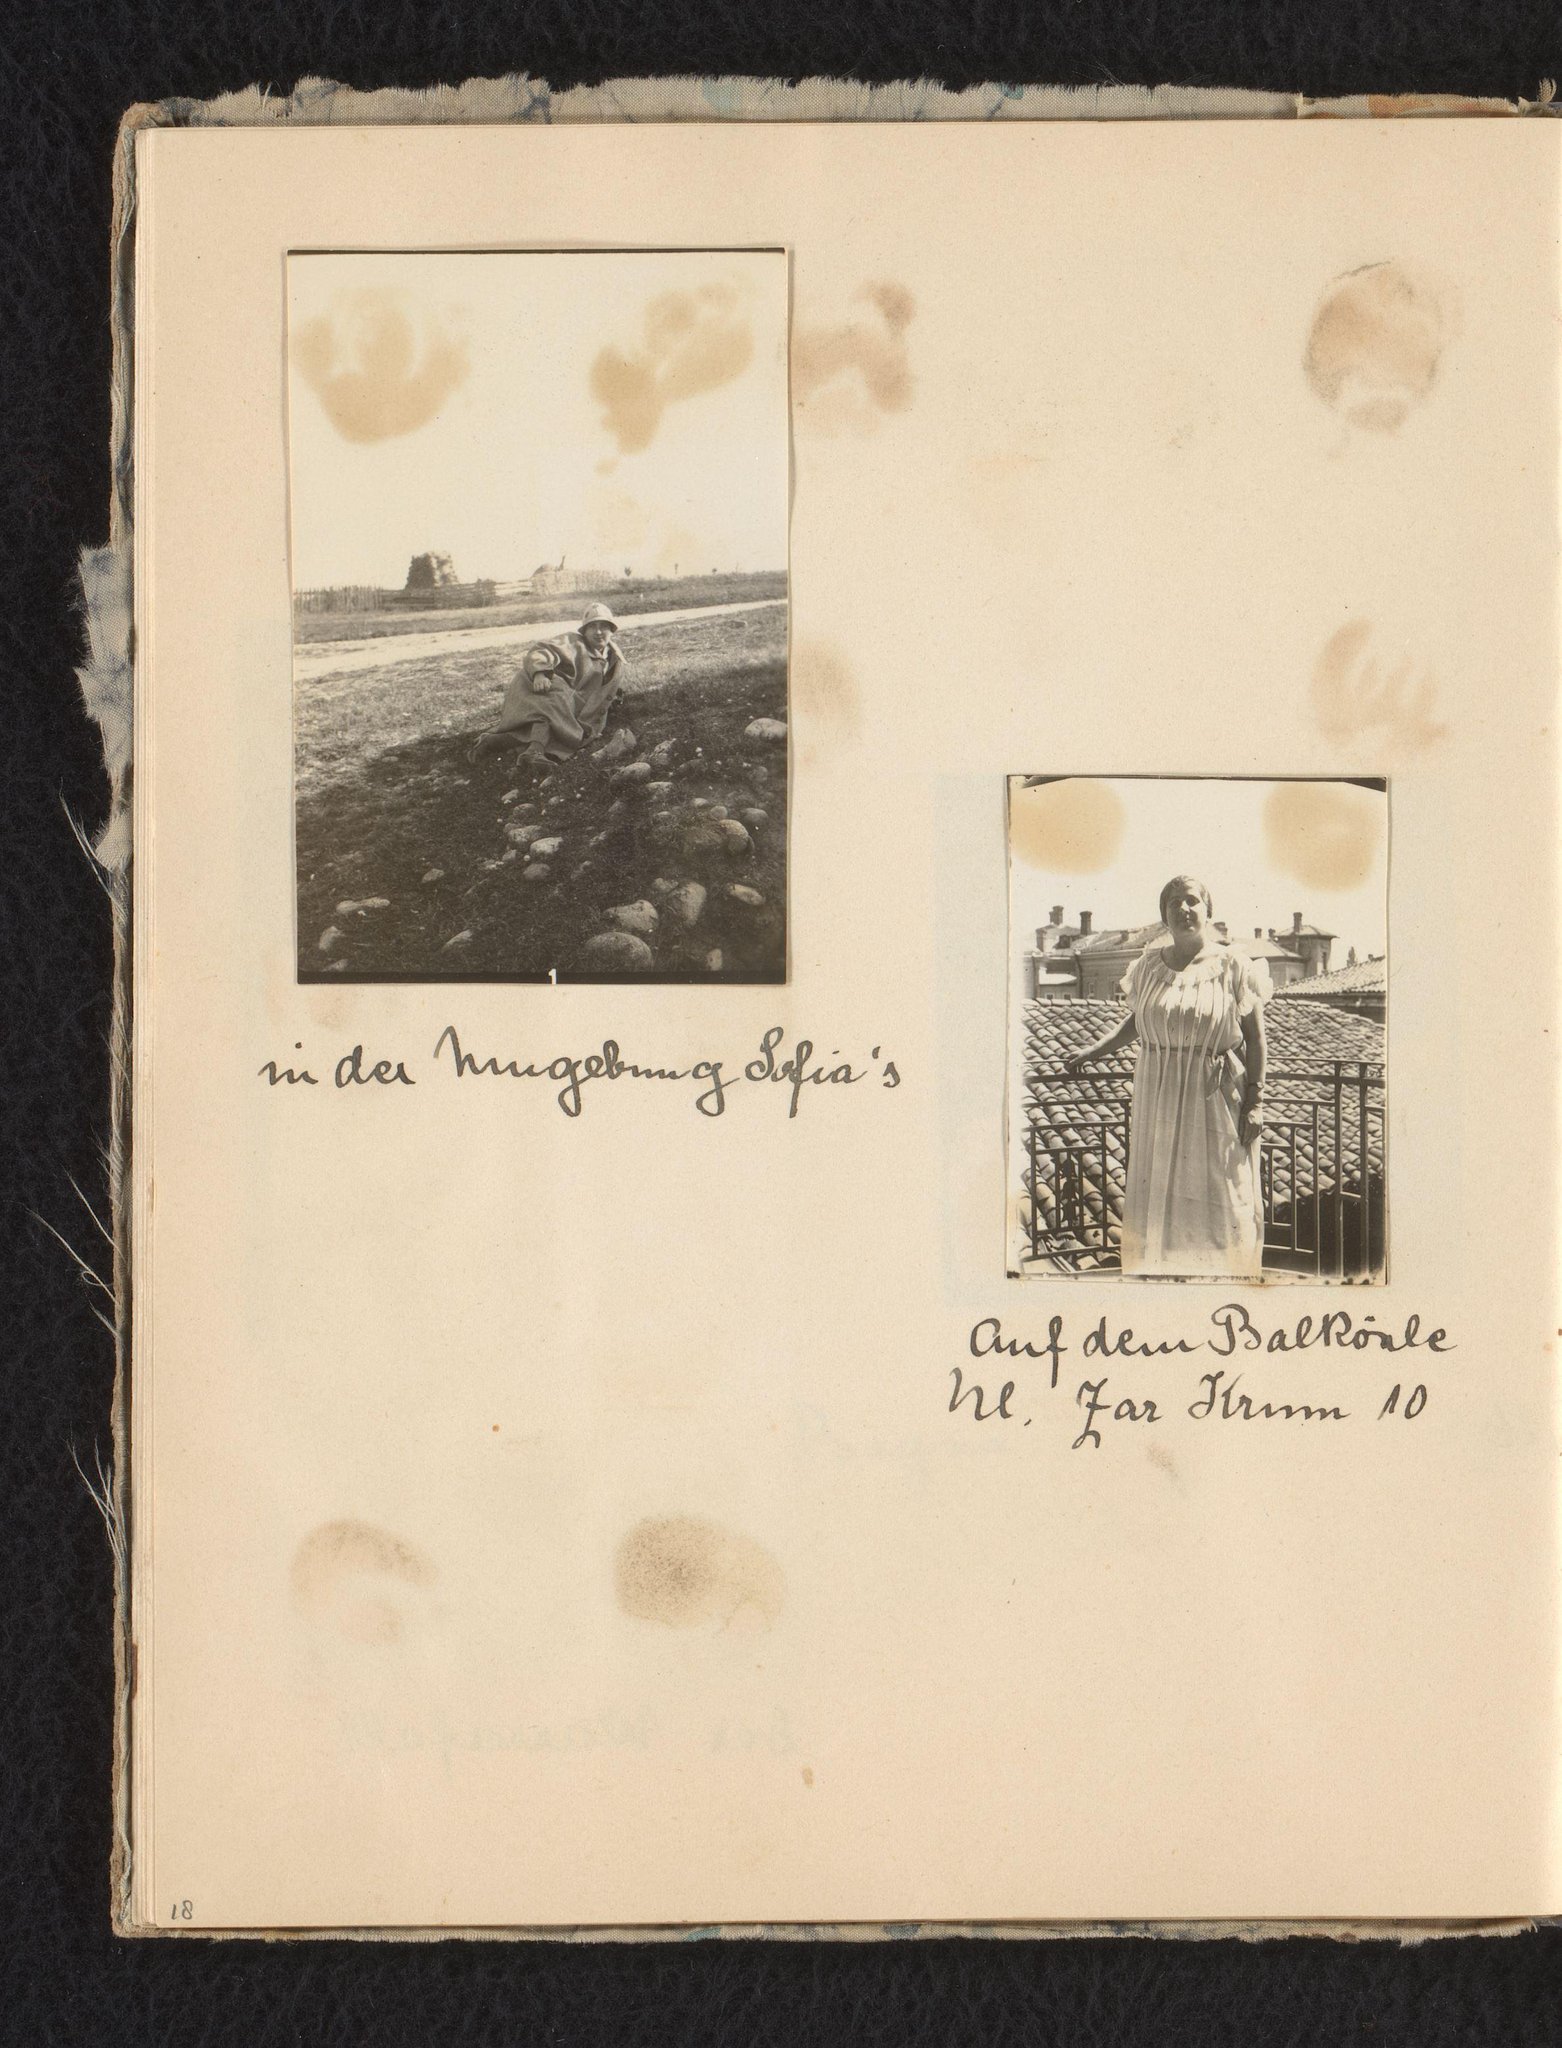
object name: photograph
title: Else Wachenheimer-Moos in een veld en op een balkon, 1926-1927, Sofia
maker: else wachenheimer-moos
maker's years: 1895-1944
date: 1926-1927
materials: paper, photographic support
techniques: gelatin silver print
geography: sofia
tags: else wachenheimer-moos, the family travelling, on holiday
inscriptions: inscription: ‘in der Umgebung Sofia's / Auf den Balkon nl. Zar Krum 10’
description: Blad bevat twee foto's van Else Wachenheimer-Moos. Onderdeel van het fotoalbum van de reizen die Eugen en Else Wachenheimer jaarlijks maakten rondom de viering van hun huwelijksdag en verloving.